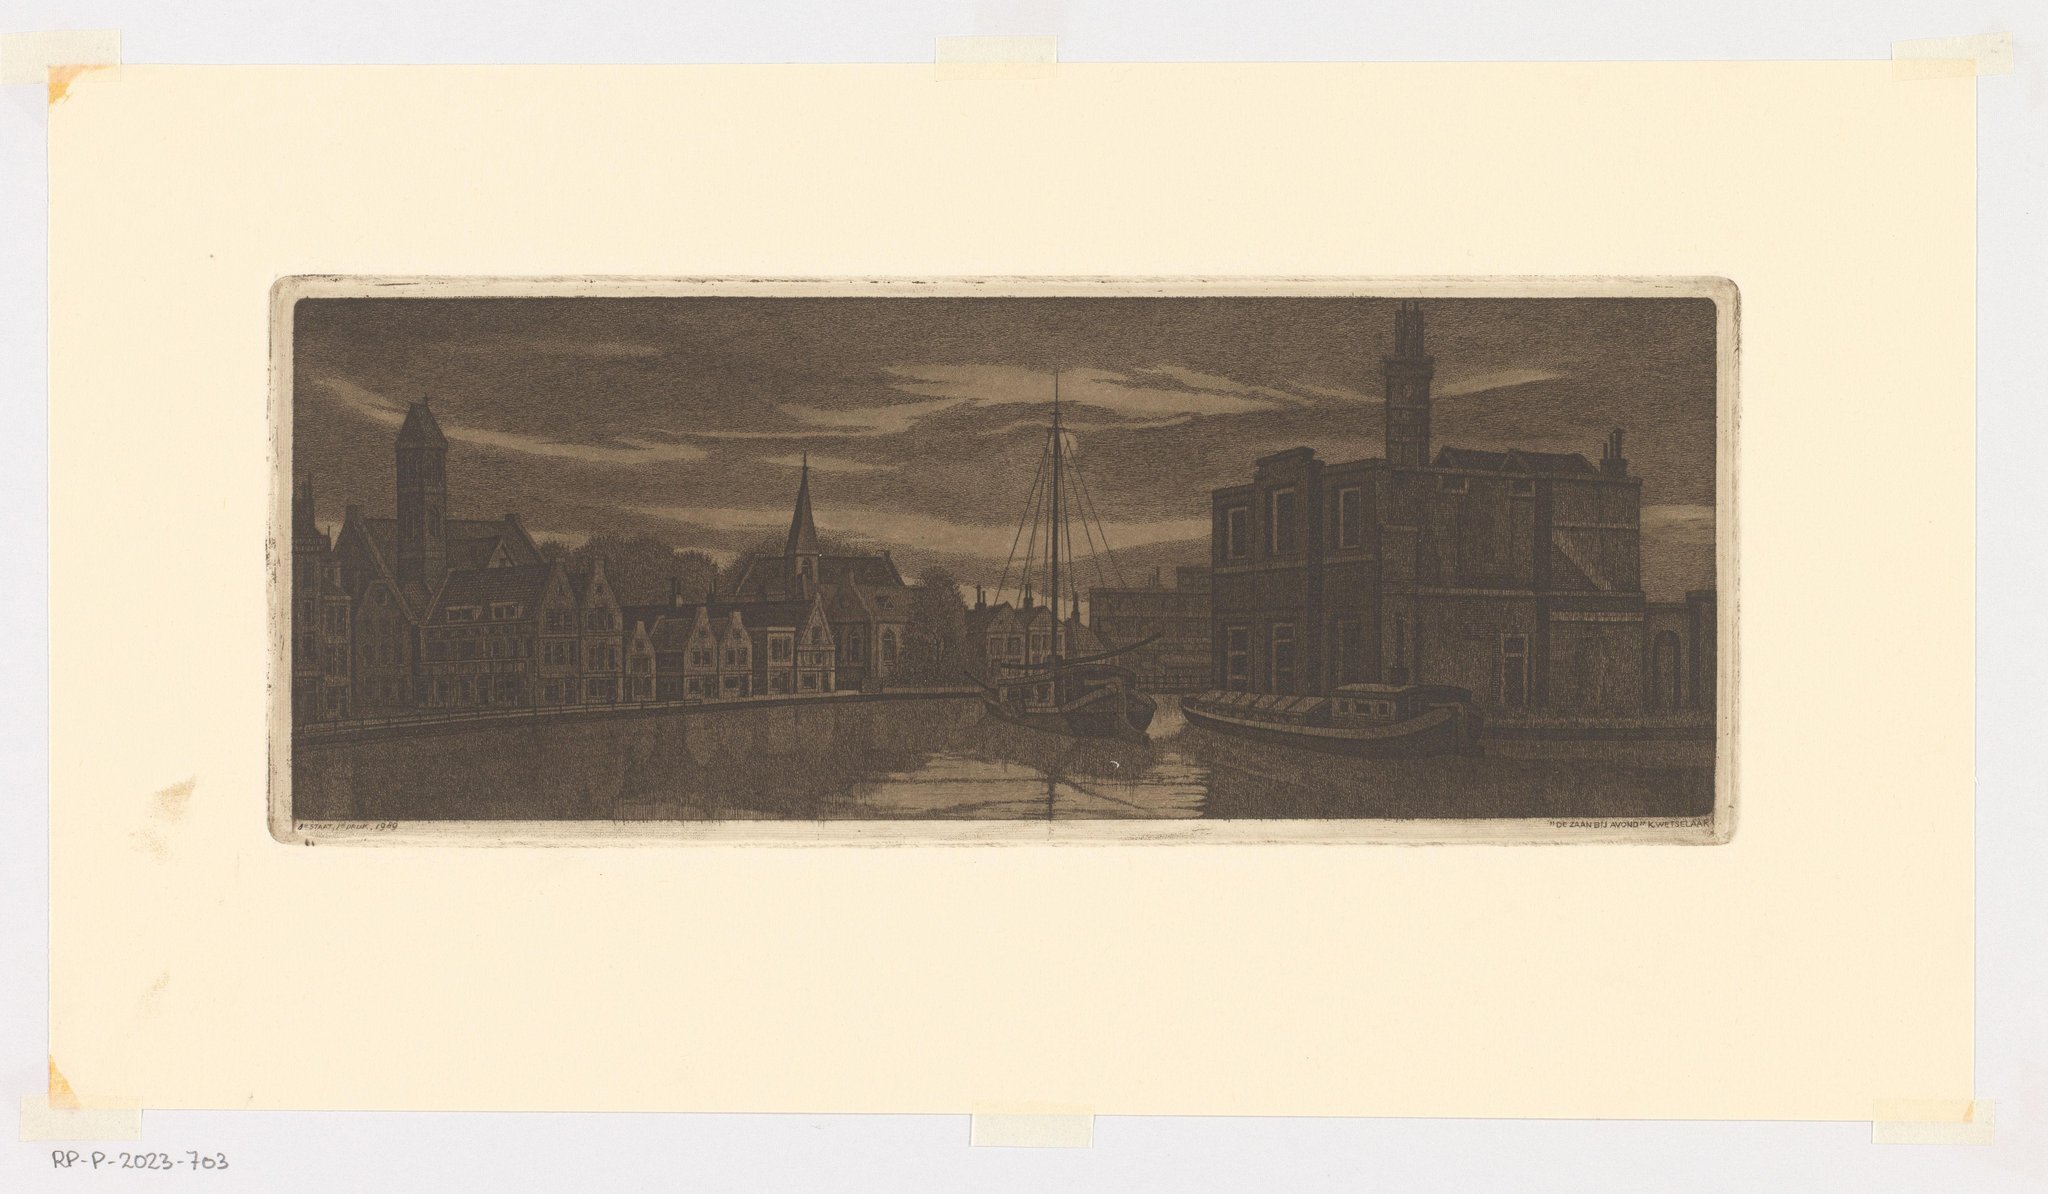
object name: print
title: De Zaan bij Avond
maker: karel wetselaar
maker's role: print maker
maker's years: 1935-2017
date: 1989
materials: paper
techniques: etching, intaglio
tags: river, village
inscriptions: date: ‘1989’, inscription: ‘8e staat, 1e druk’, signature: ‘K. Wetselaar’